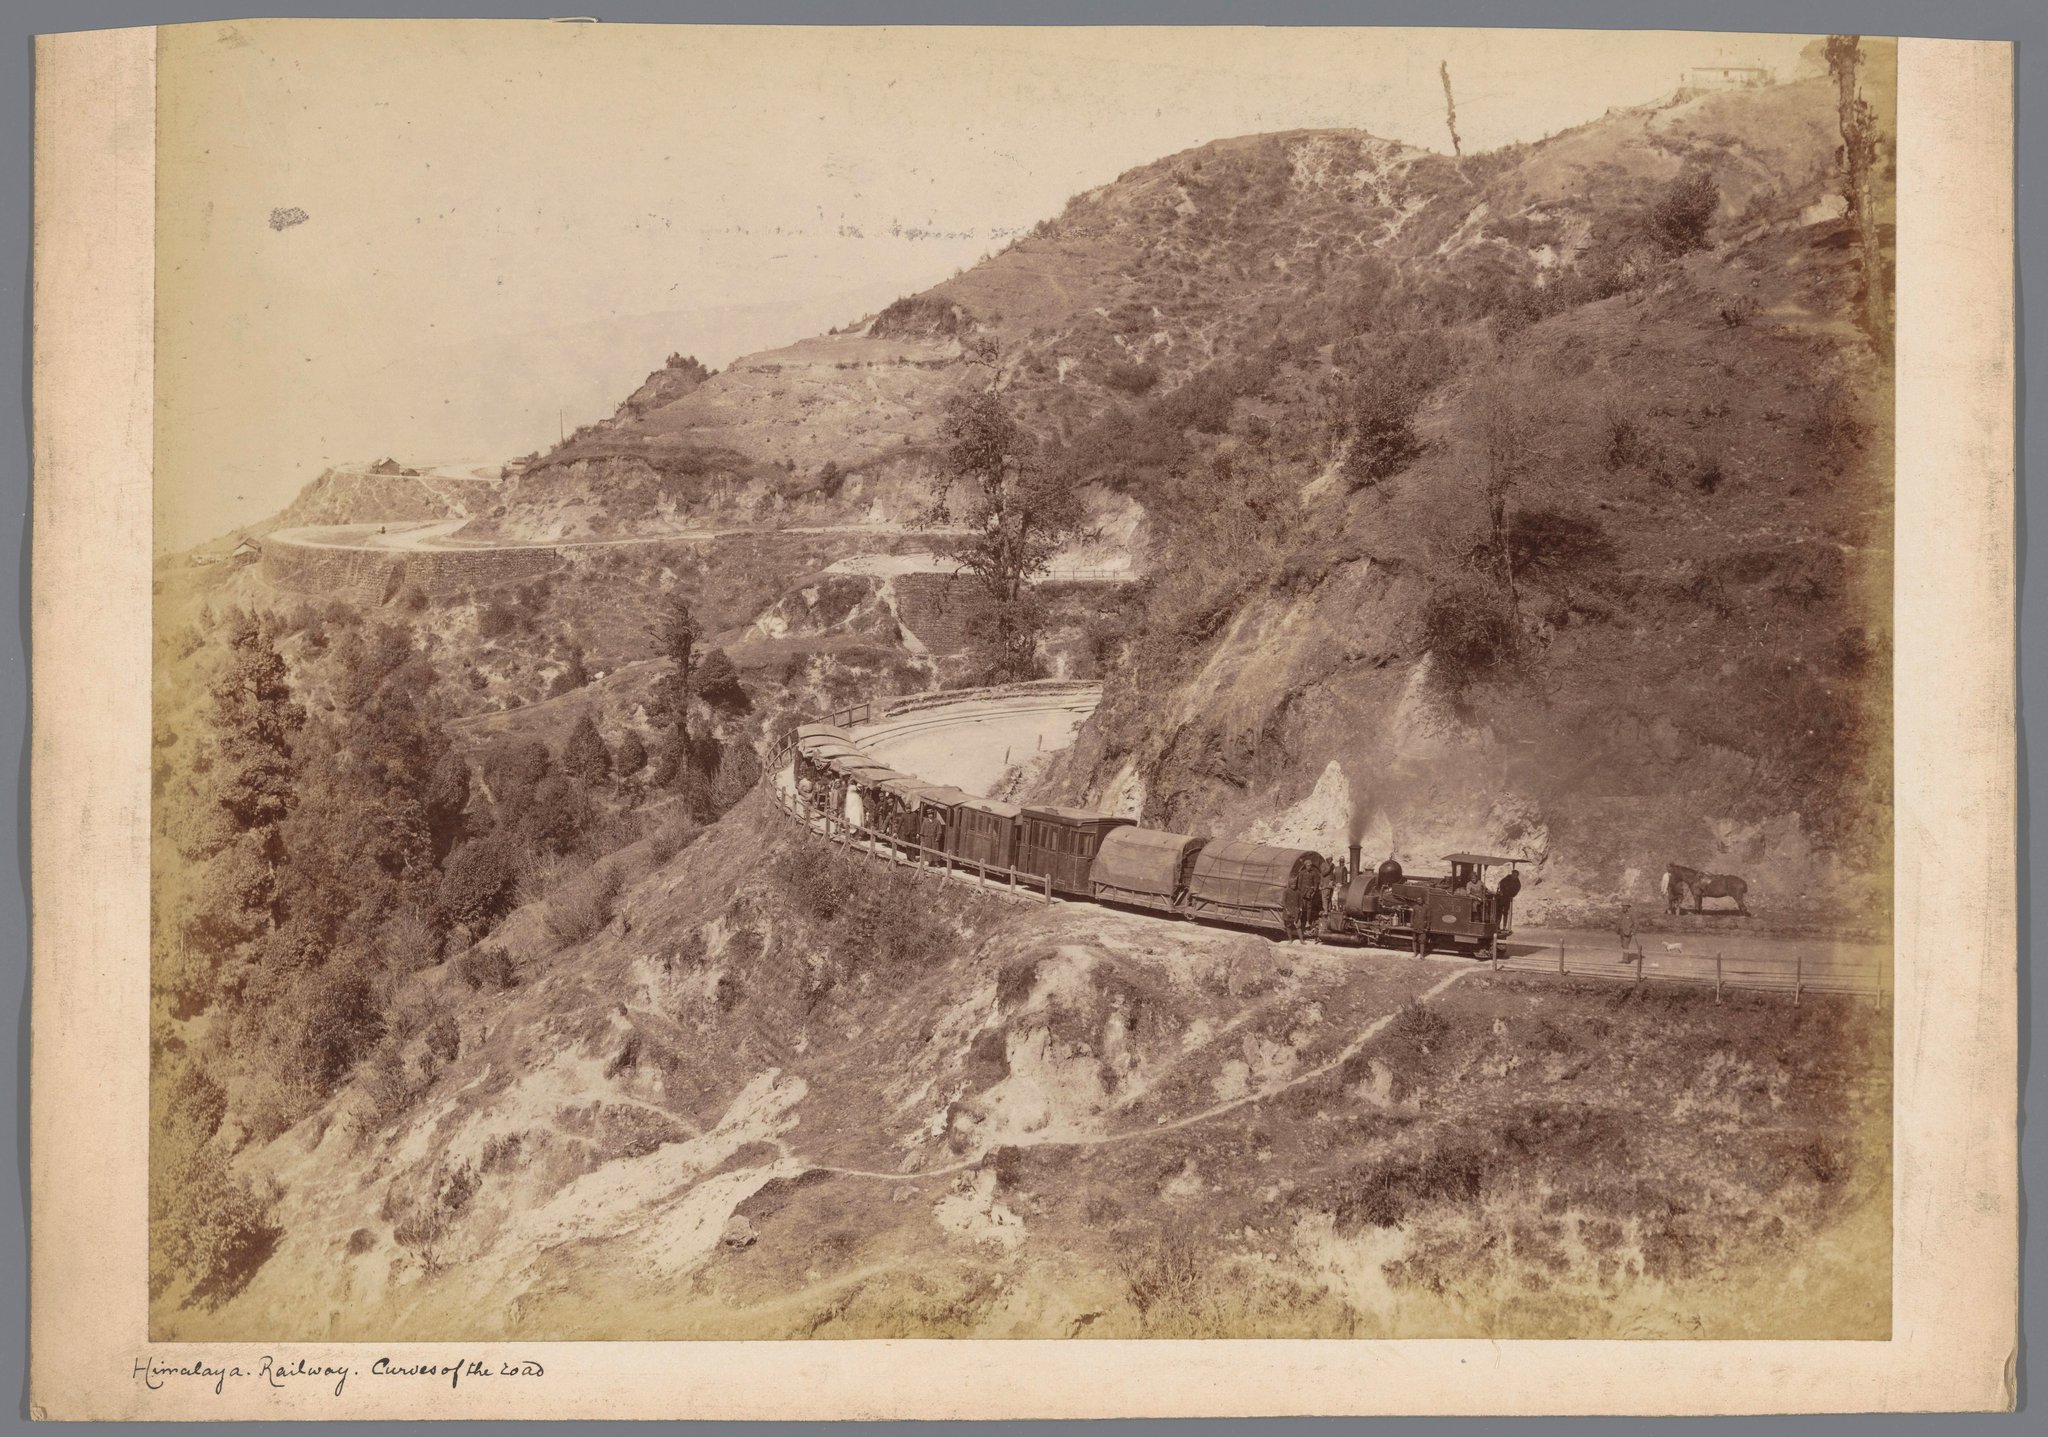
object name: photograph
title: Darjeeling Himalayan Railway, West Bengal, India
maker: Anonymous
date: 1884-1890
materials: cardboard, paper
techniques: albumen print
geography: west bengal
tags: railway, train, mountains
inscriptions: number: ‘66’, title: ‘Himalaya. Railway. Curves of the road’